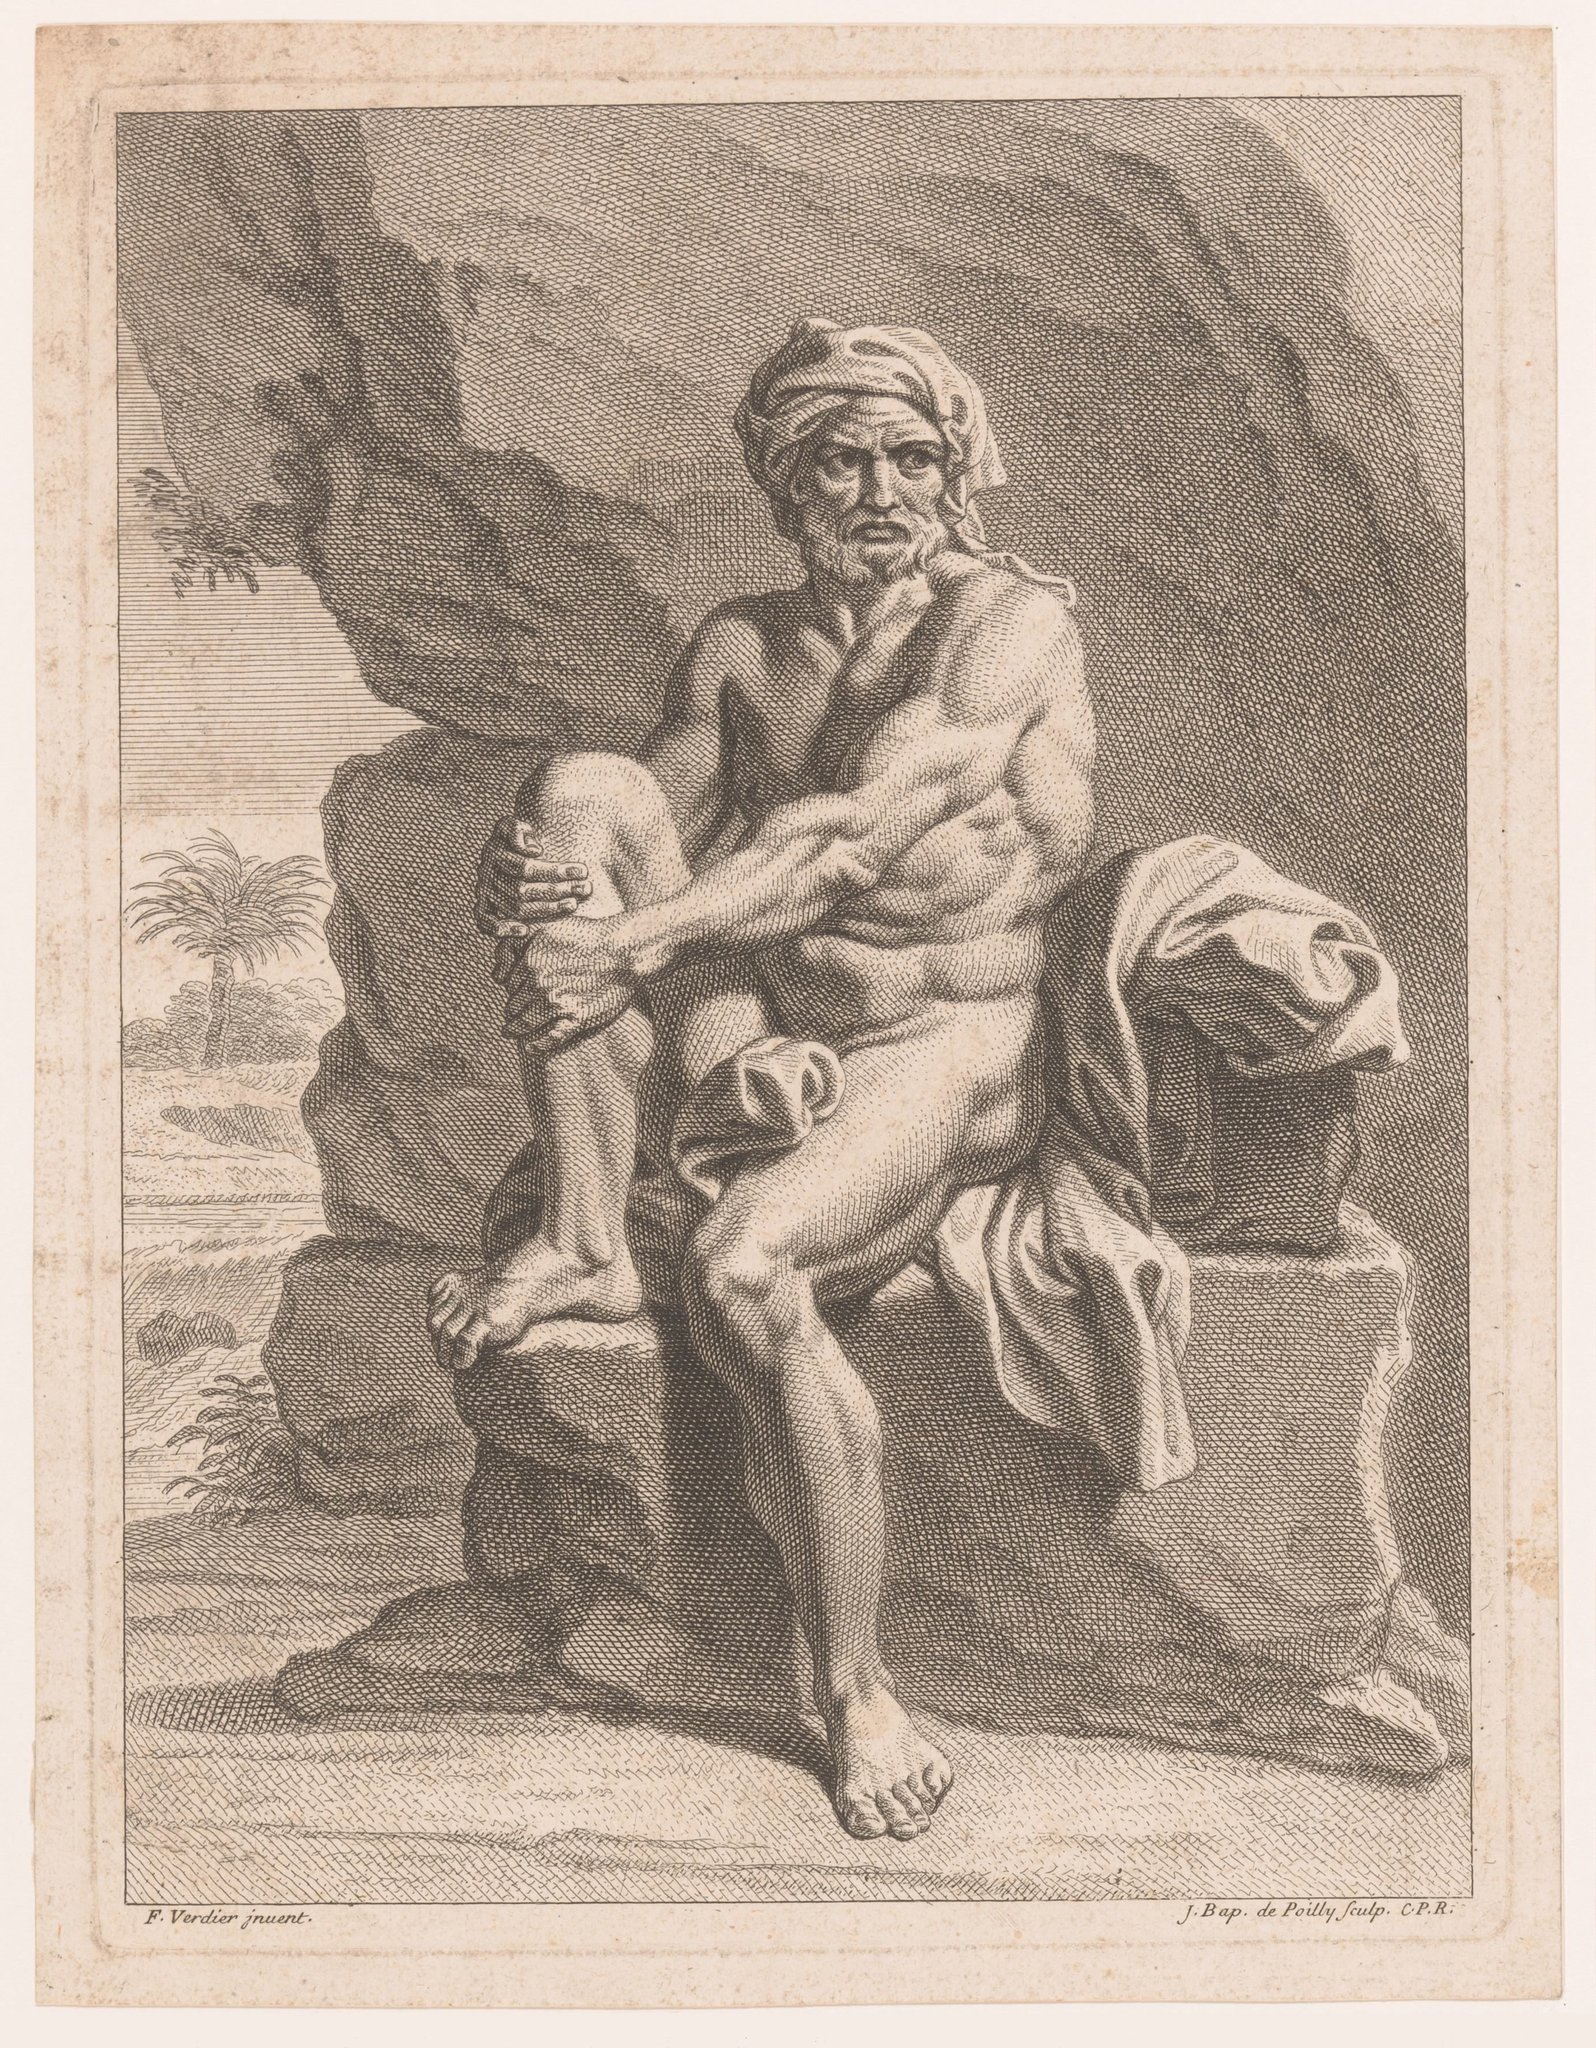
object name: print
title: Verzameling van figuren getekend op de Academie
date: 1679-1728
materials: paper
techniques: engraving, etching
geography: france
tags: adult man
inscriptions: collector's mark: Lugt 2228